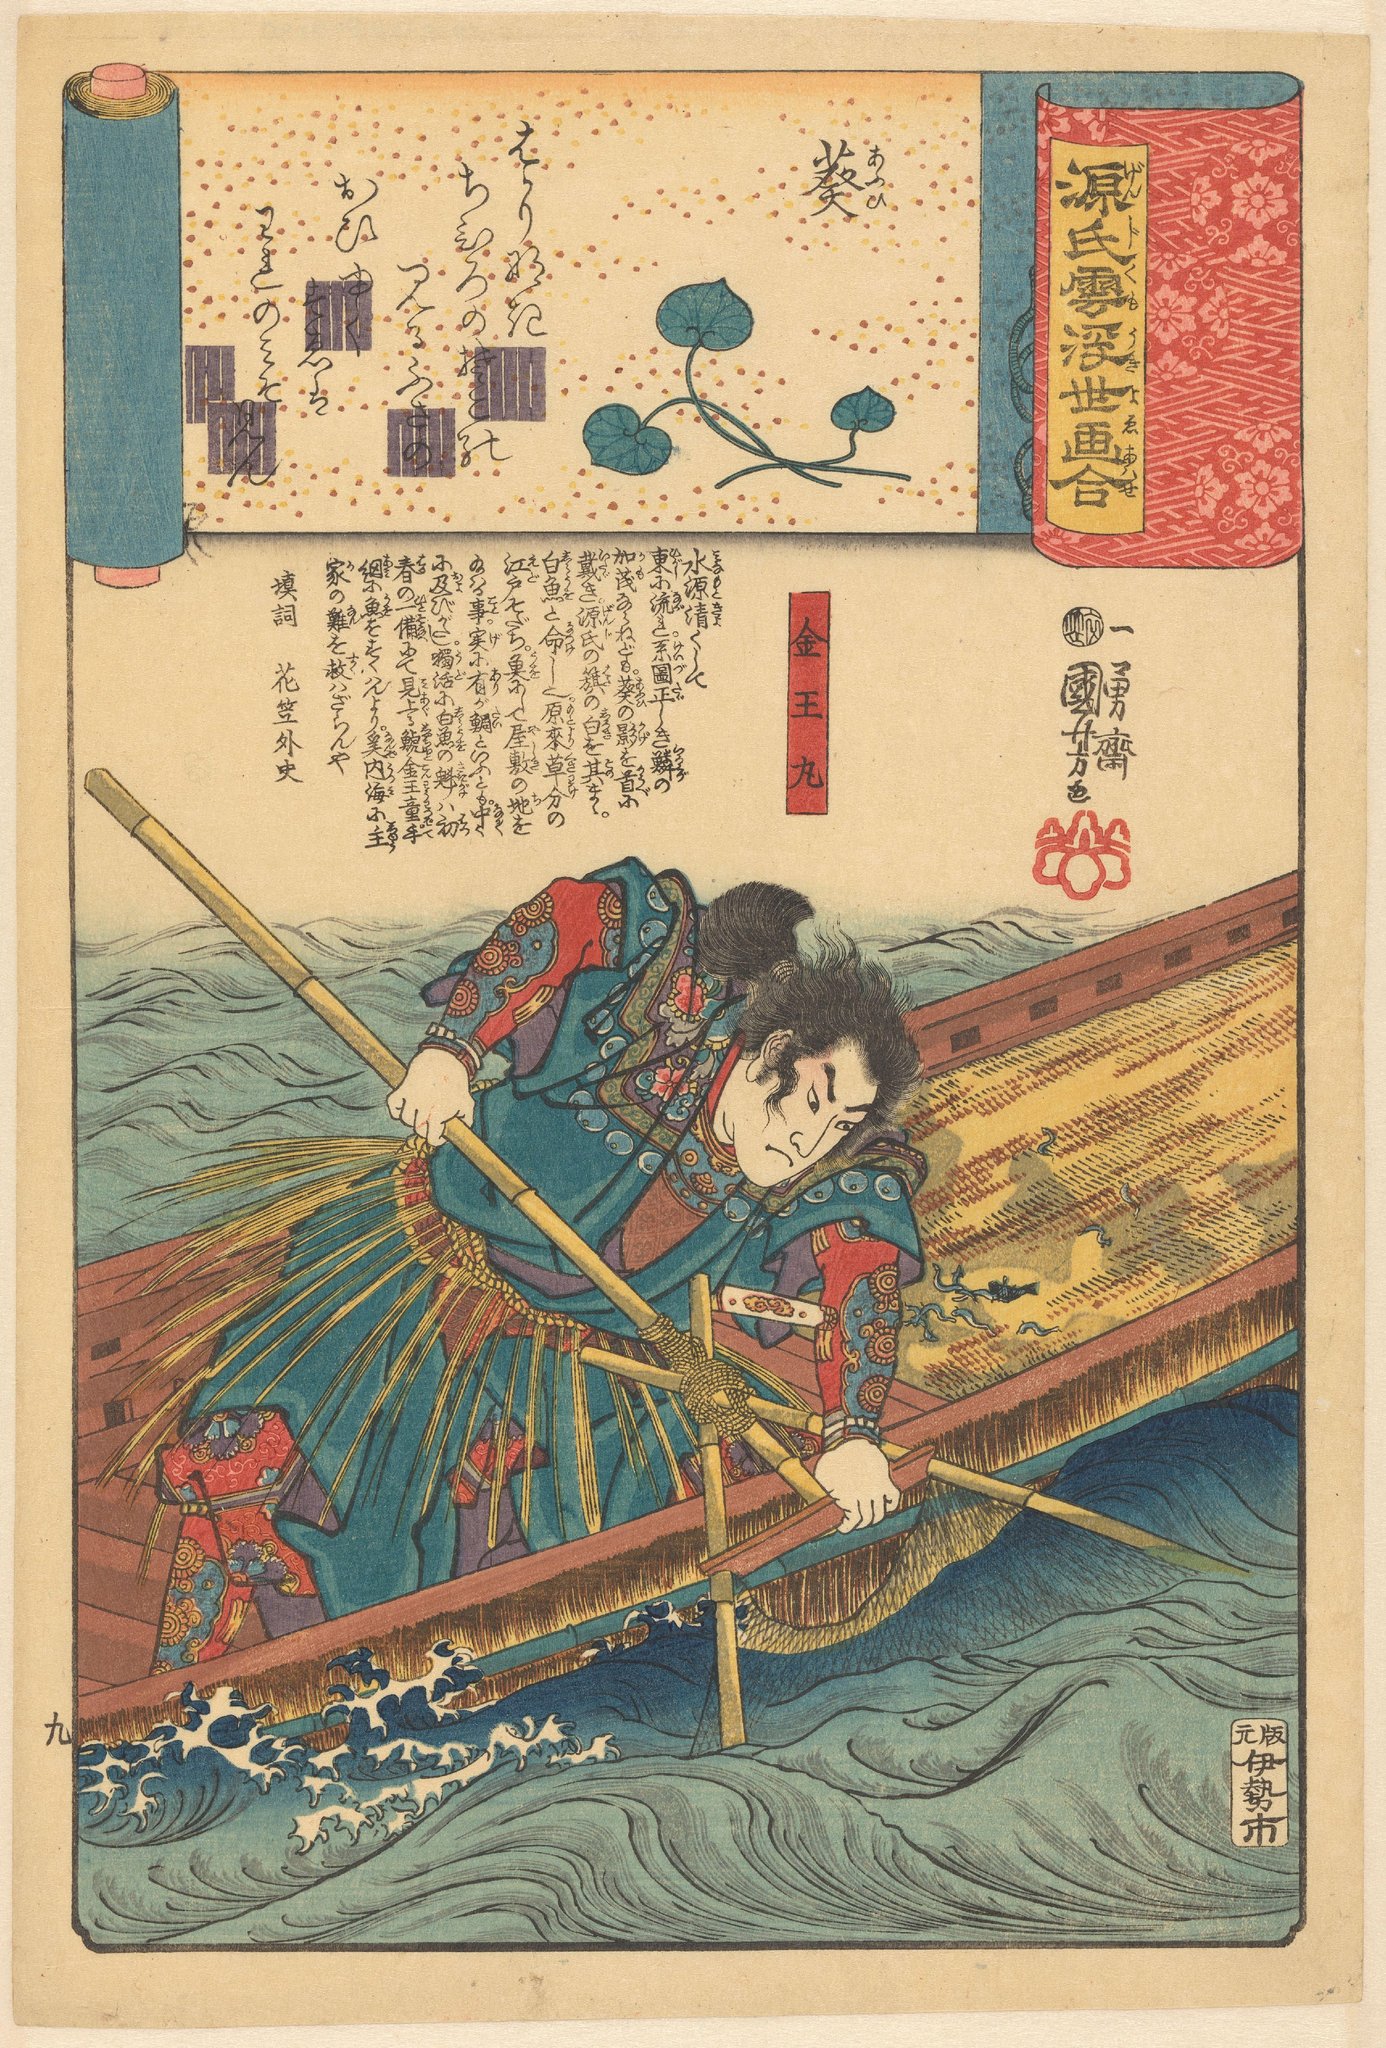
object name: print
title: Ukiyo e parallels to the cloudy chapters of the Genji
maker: utagawa kuniyoshi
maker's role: draughtsman, print maker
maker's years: 1798-1861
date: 1846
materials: paper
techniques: woodcut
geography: japan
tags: adult man, rowing-boat, canoe, etc., fishing (sports)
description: Shibuya Konnômaru vissend vanuit een boot naar zeebaars.